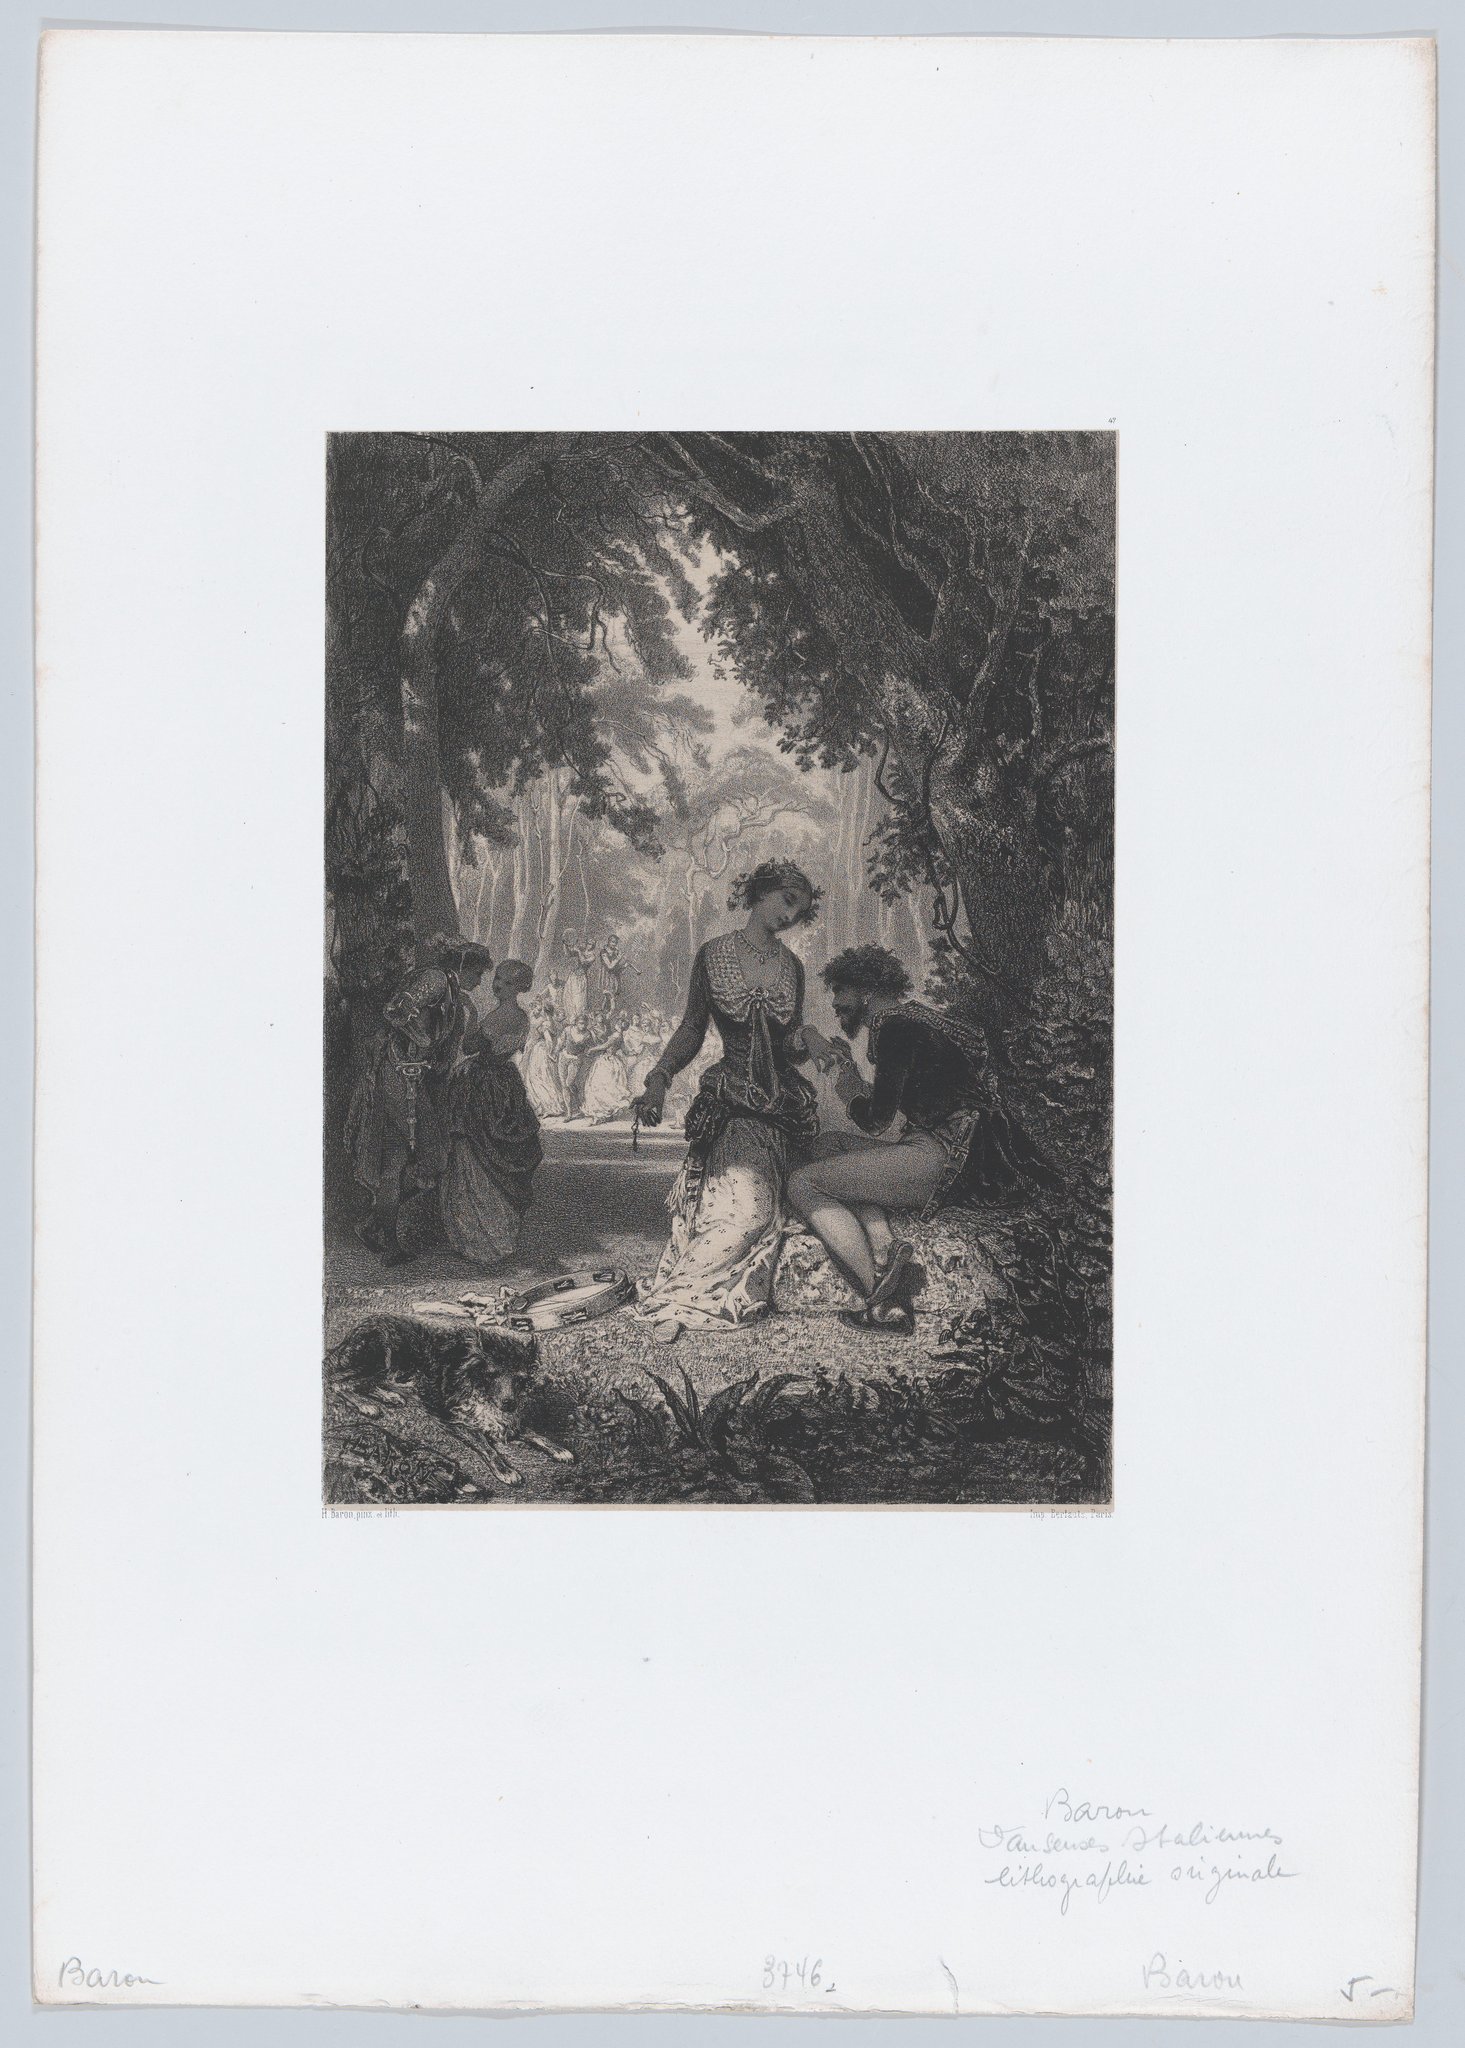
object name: print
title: Love Sermons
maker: henri-charles-antoine baron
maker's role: artist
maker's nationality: french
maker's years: 1816-1885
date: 1853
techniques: lithograph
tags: couples,men,women,dogs